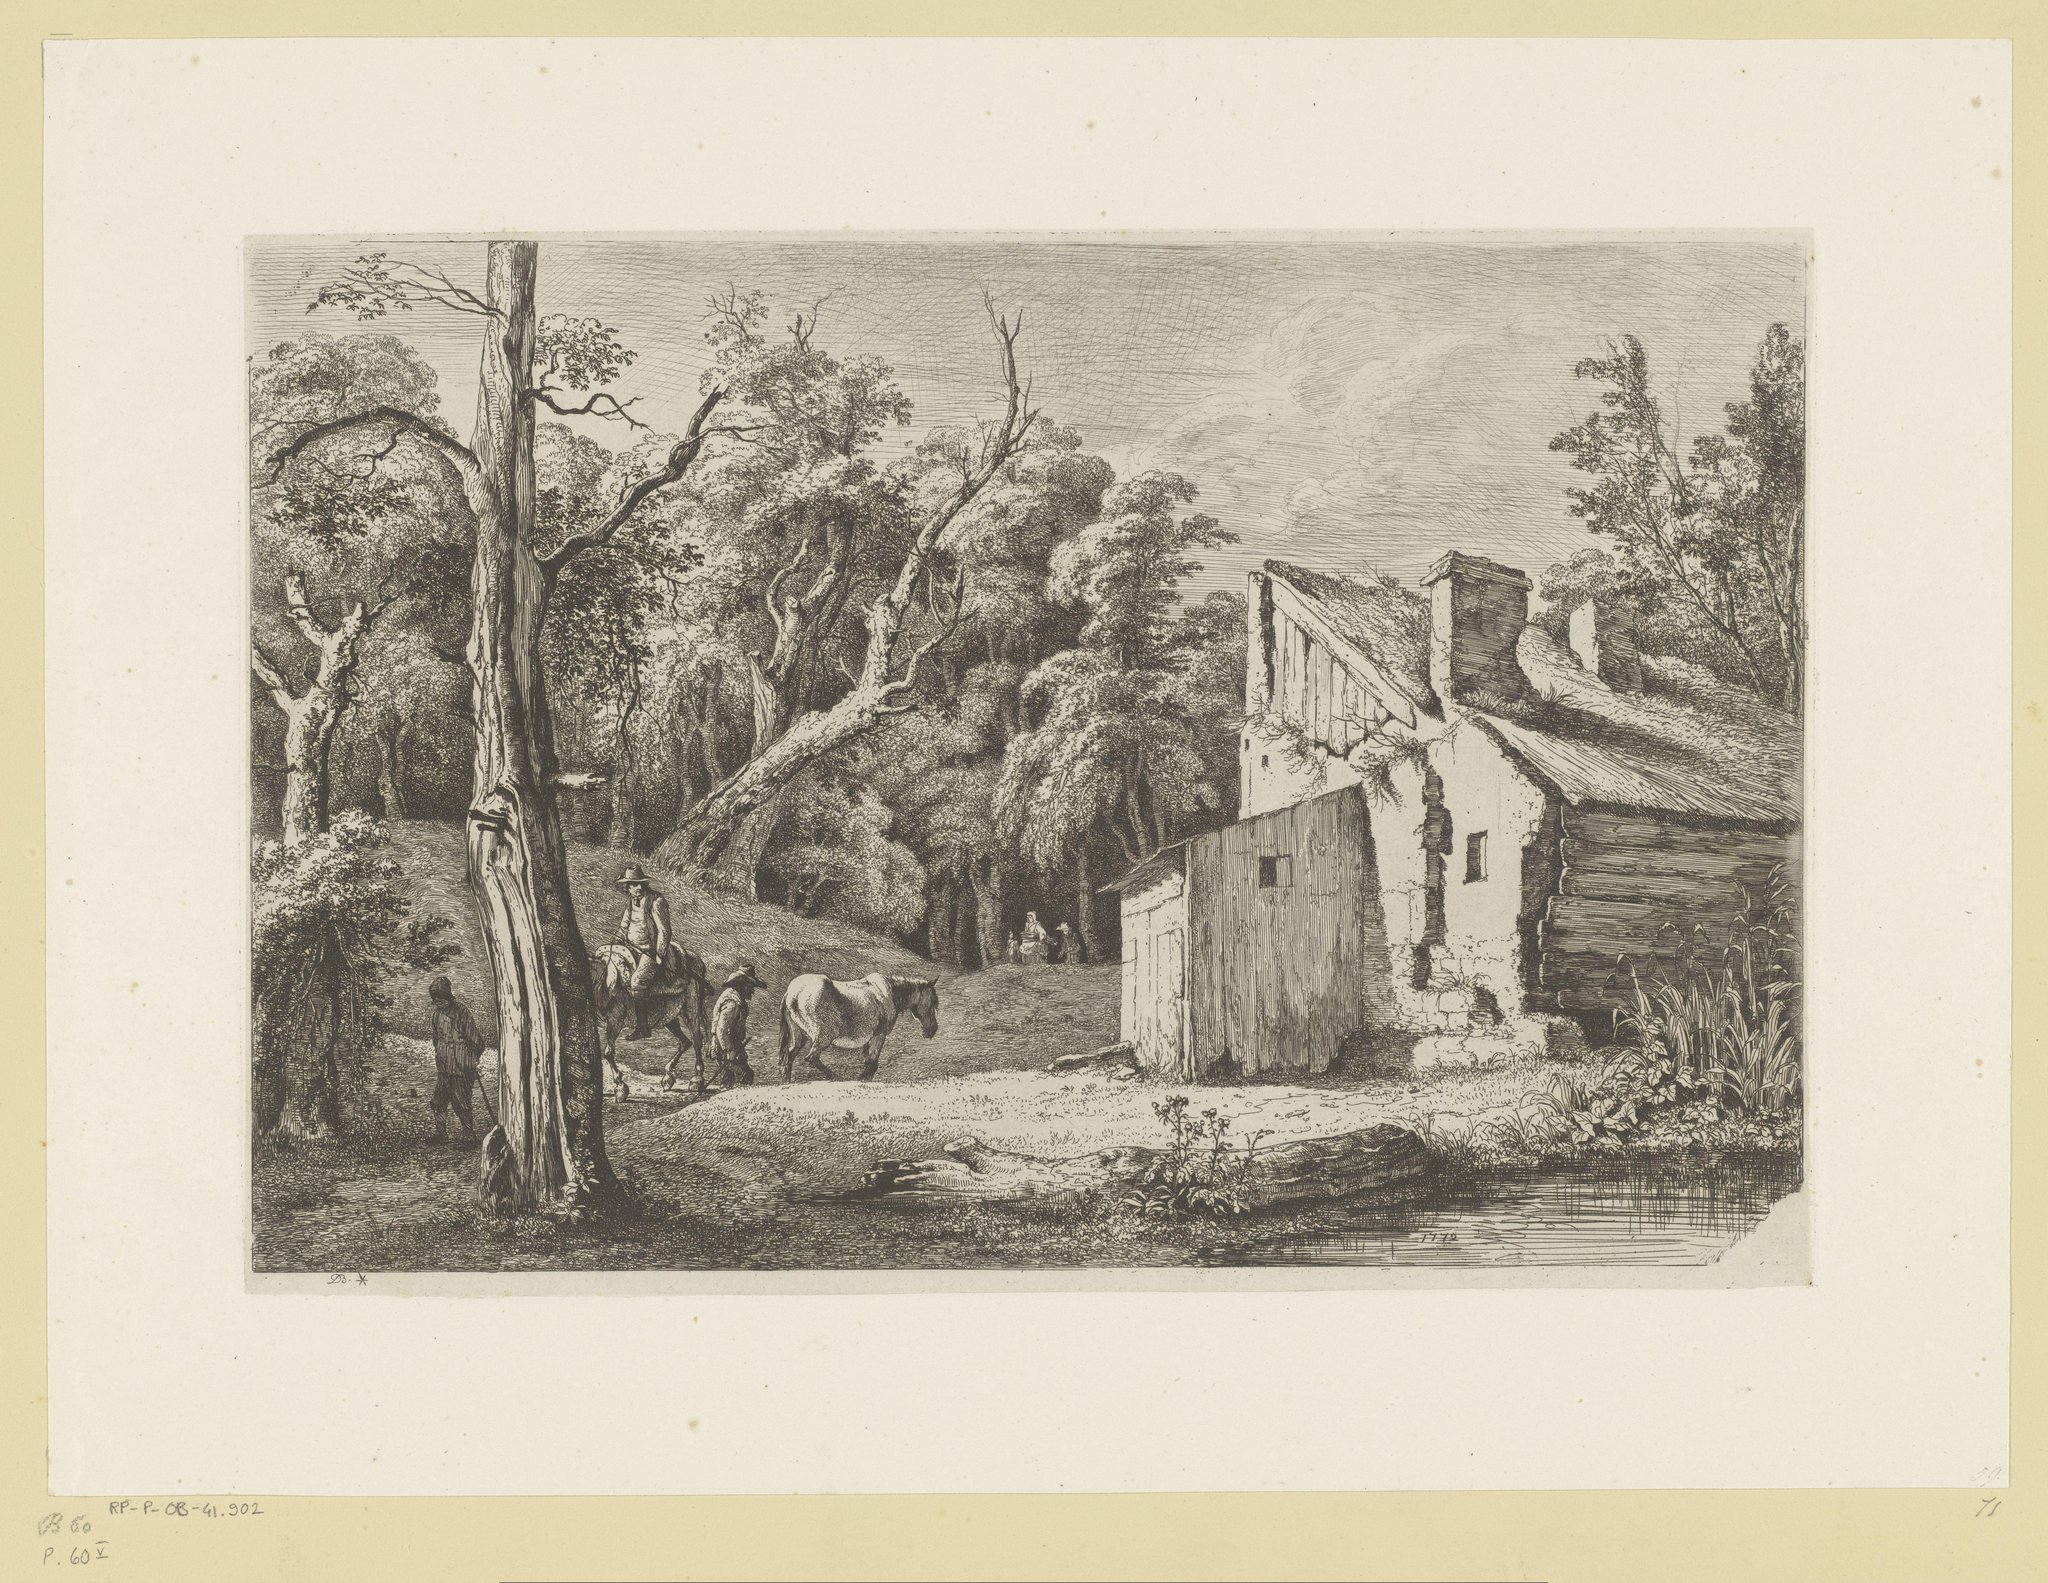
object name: print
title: Landschap met figuren voor een huis aan de rand van een bos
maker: jean jacques de boissieu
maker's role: draughtsman, print maker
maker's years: 1736-1810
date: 1772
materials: paper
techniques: drypoint, etching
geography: france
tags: forest, wood, landscapes (+ landscape with figures, staffage)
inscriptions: collector's mark: Lugt 12